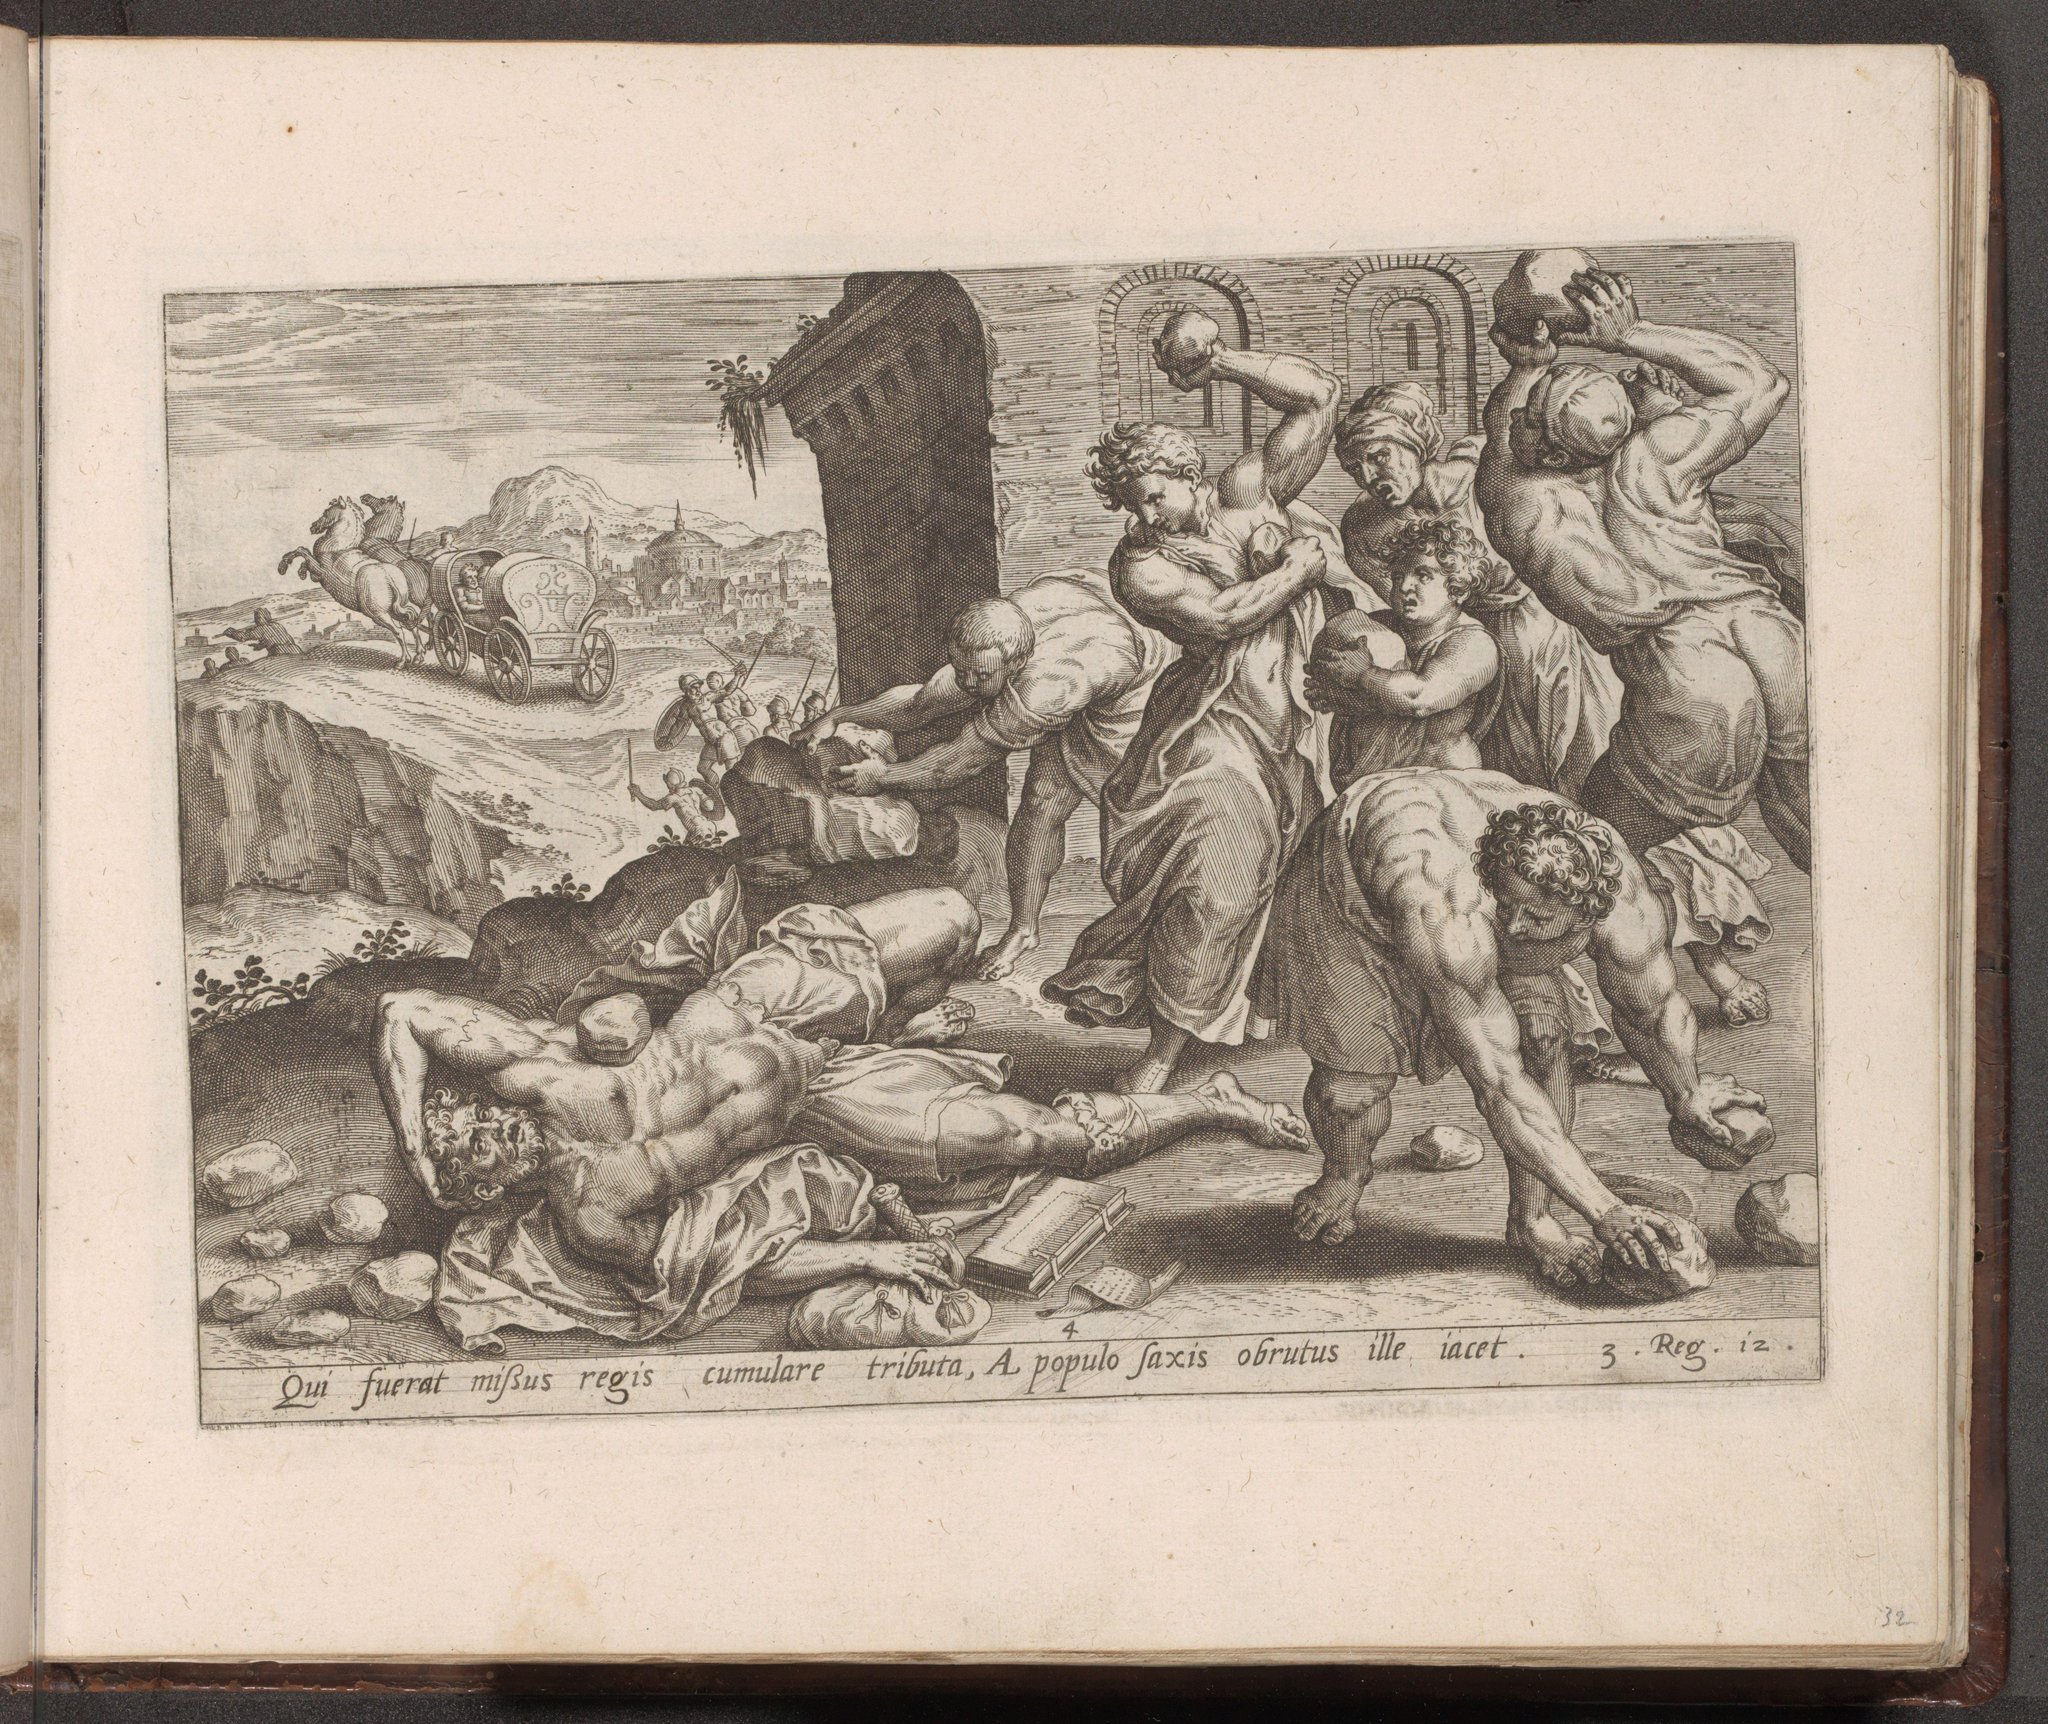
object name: print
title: Historia Roboam et Jeroboam (...)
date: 1579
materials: paper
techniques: engraving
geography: antwerp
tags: purse, money-bag, adoram is stoned to death; rehoboam escapes in his chariot to jerusalem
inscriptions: caption: ‘Qui fuerat missus regis...ille iacet. 3. Reg. 12.’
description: Koning Rechabeam stuurde Adoniram, zijn opzichter van de herendienst, naar de opstandige Israëlieten. De mensen stenigen Adoniram, die zijn hand houdt op een stokbeurs, die hij vermoedelijk wilde gebruiken bij het innen van de belastingen. Op de achtergrond ontsnapt koning Rechabeam in zijn koets naar Jeruzalem. Onder de voorstelling een verwijzing in het Latijn naar de Bijbeltekst in 1 Kon. 12. Prent maakt deel uit van een album.